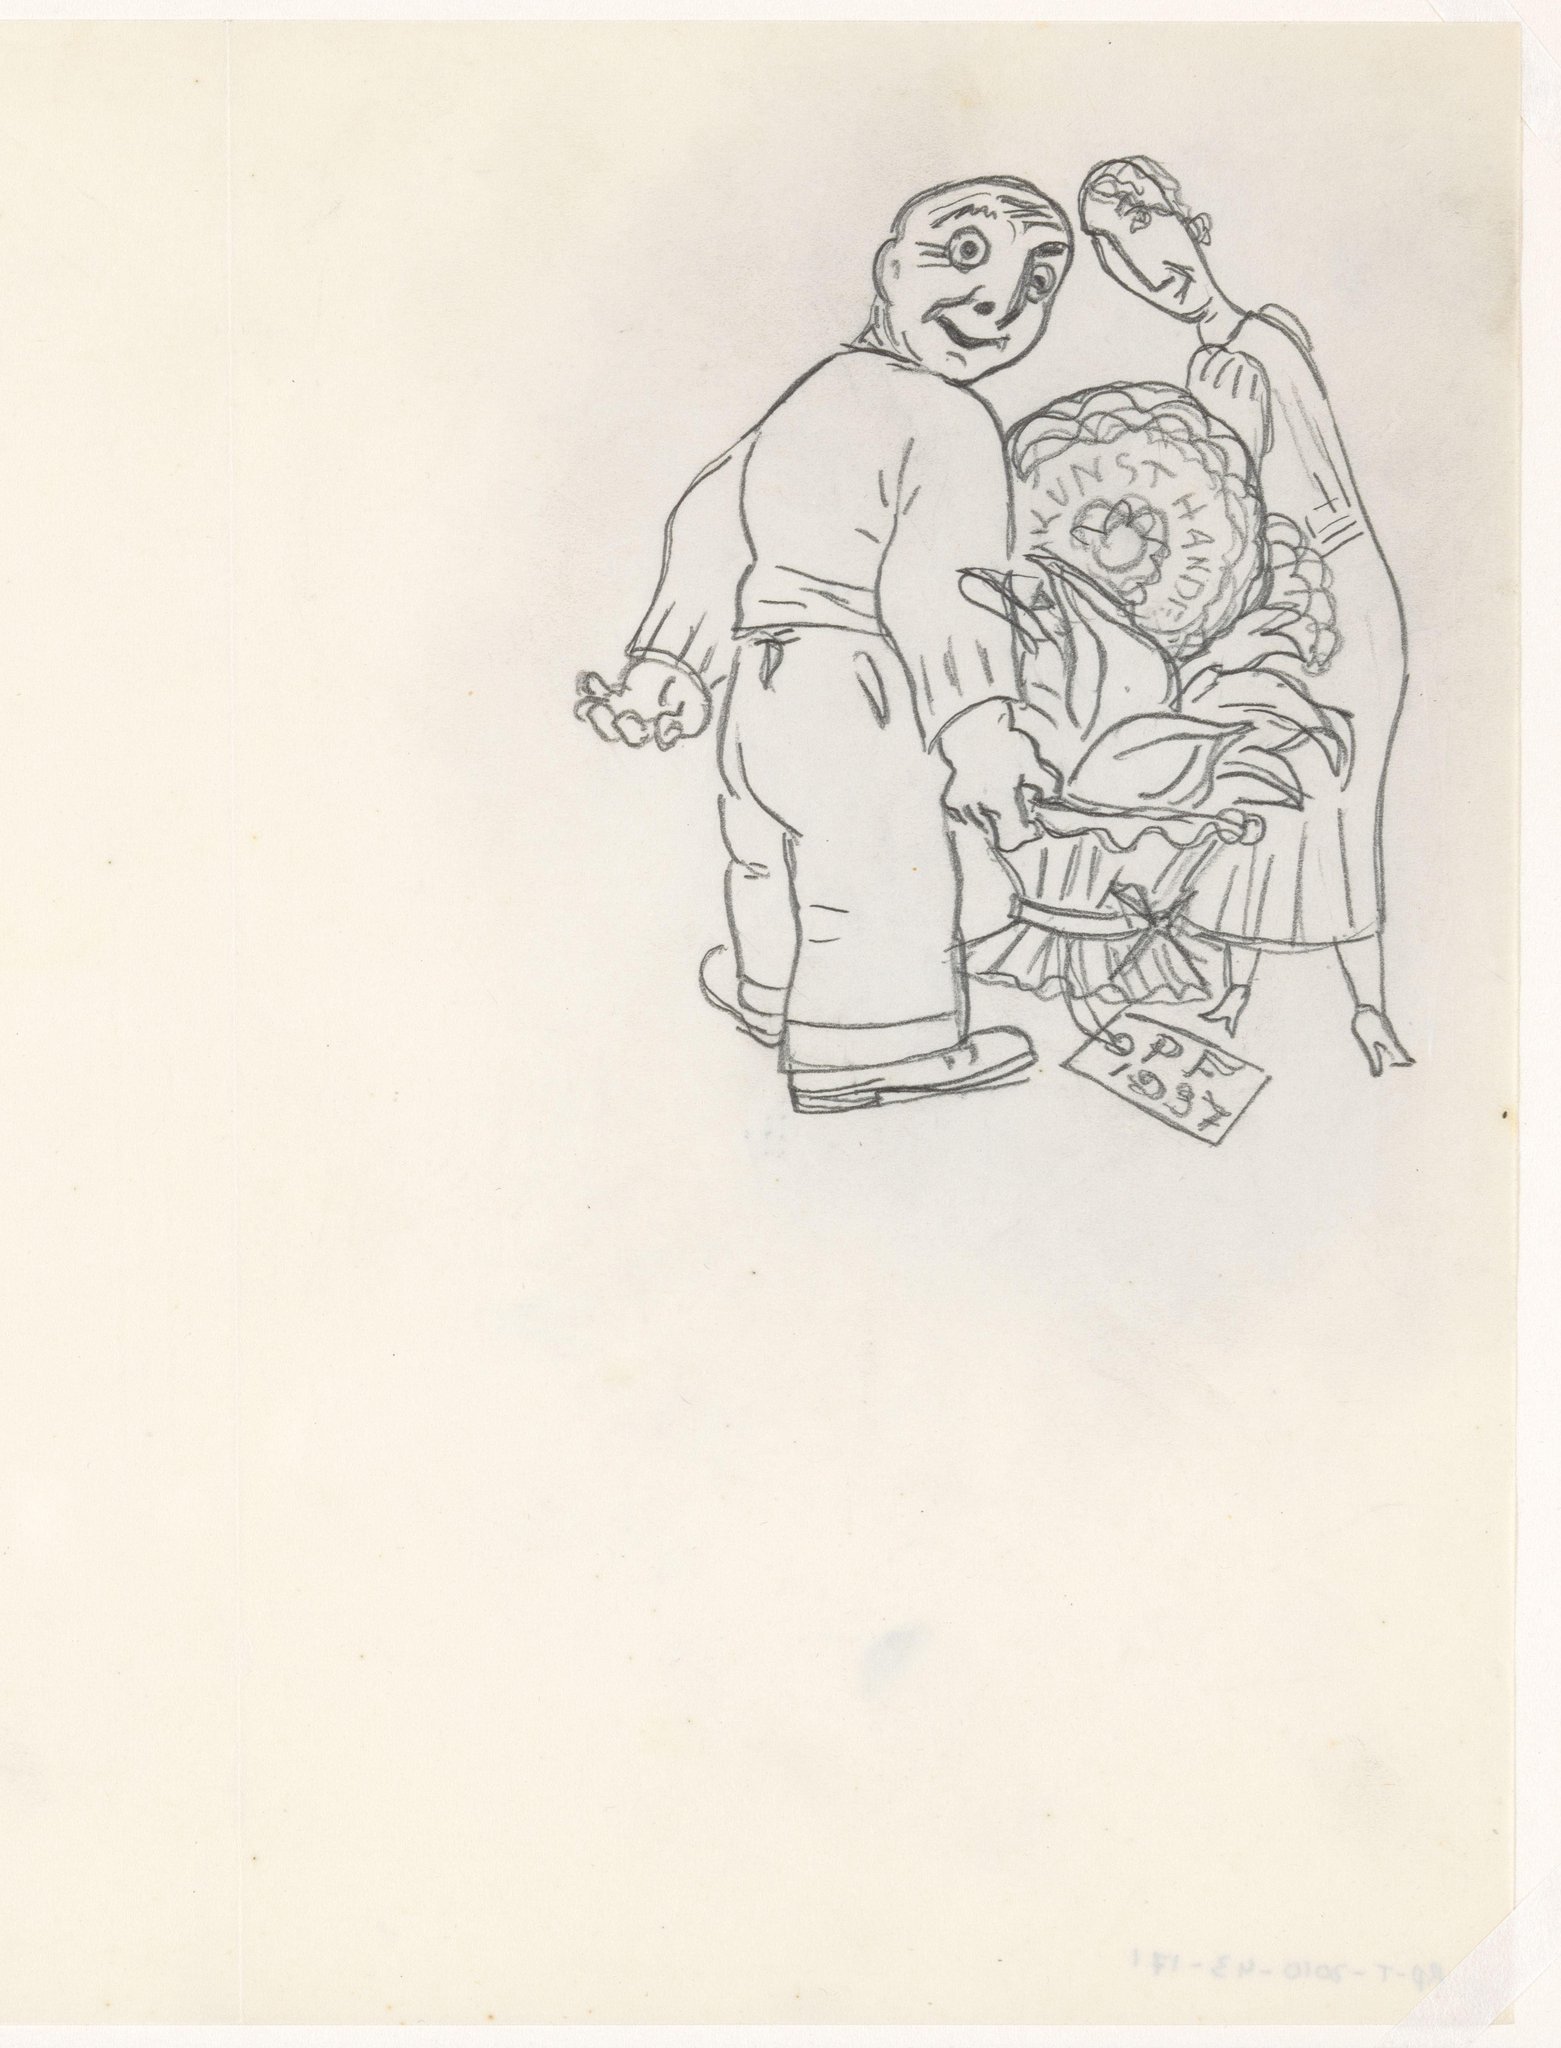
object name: greeting card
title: Ontwerp voor een wenskaart voor 1937 van Leo Gestel en An Overtoom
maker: leo gestel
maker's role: draughtsman, print maker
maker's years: 1881-1941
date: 1937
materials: ink, paper, pencil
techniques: brush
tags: print maker, draughtsman, leo gestel, amsterdam, painter, gerritje gestel-overtoom, flowers, adult woman, adult man